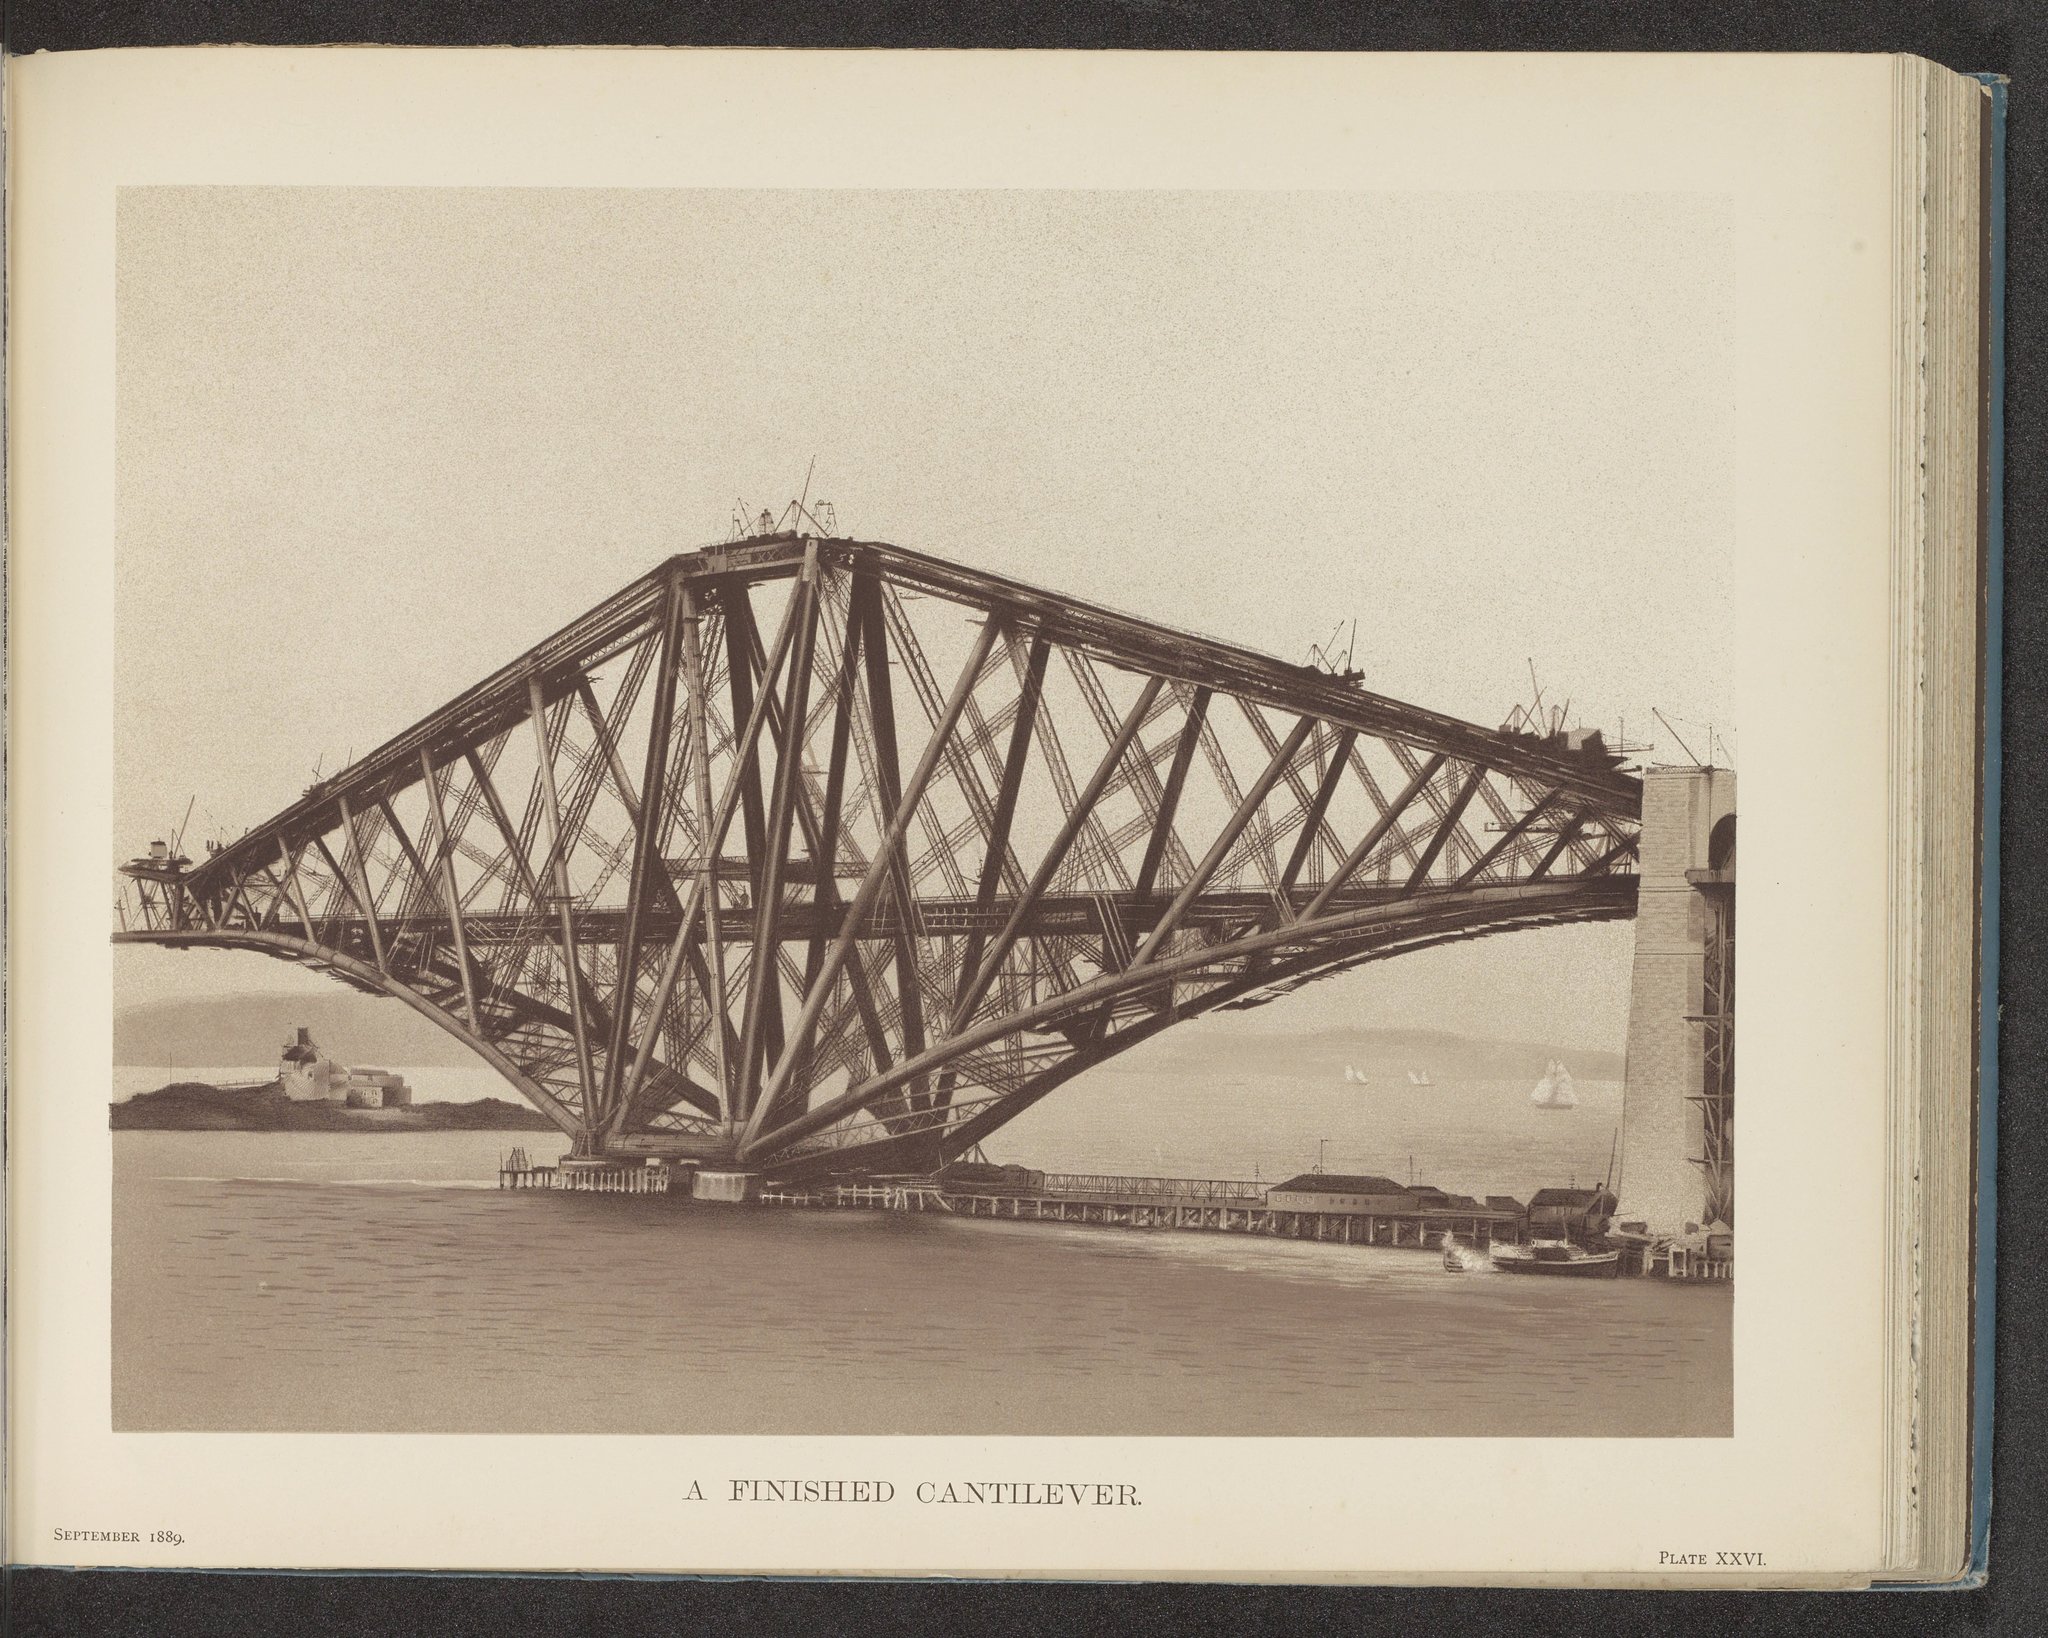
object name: photomechanical print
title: A finished cantilever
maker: Anonymous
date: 1809-1889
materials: paper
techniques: photograph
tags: building materials, landscape with bridge, viaduct or aqueduct, bridge, building-site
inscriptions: number: ‘Plate XXVI.’